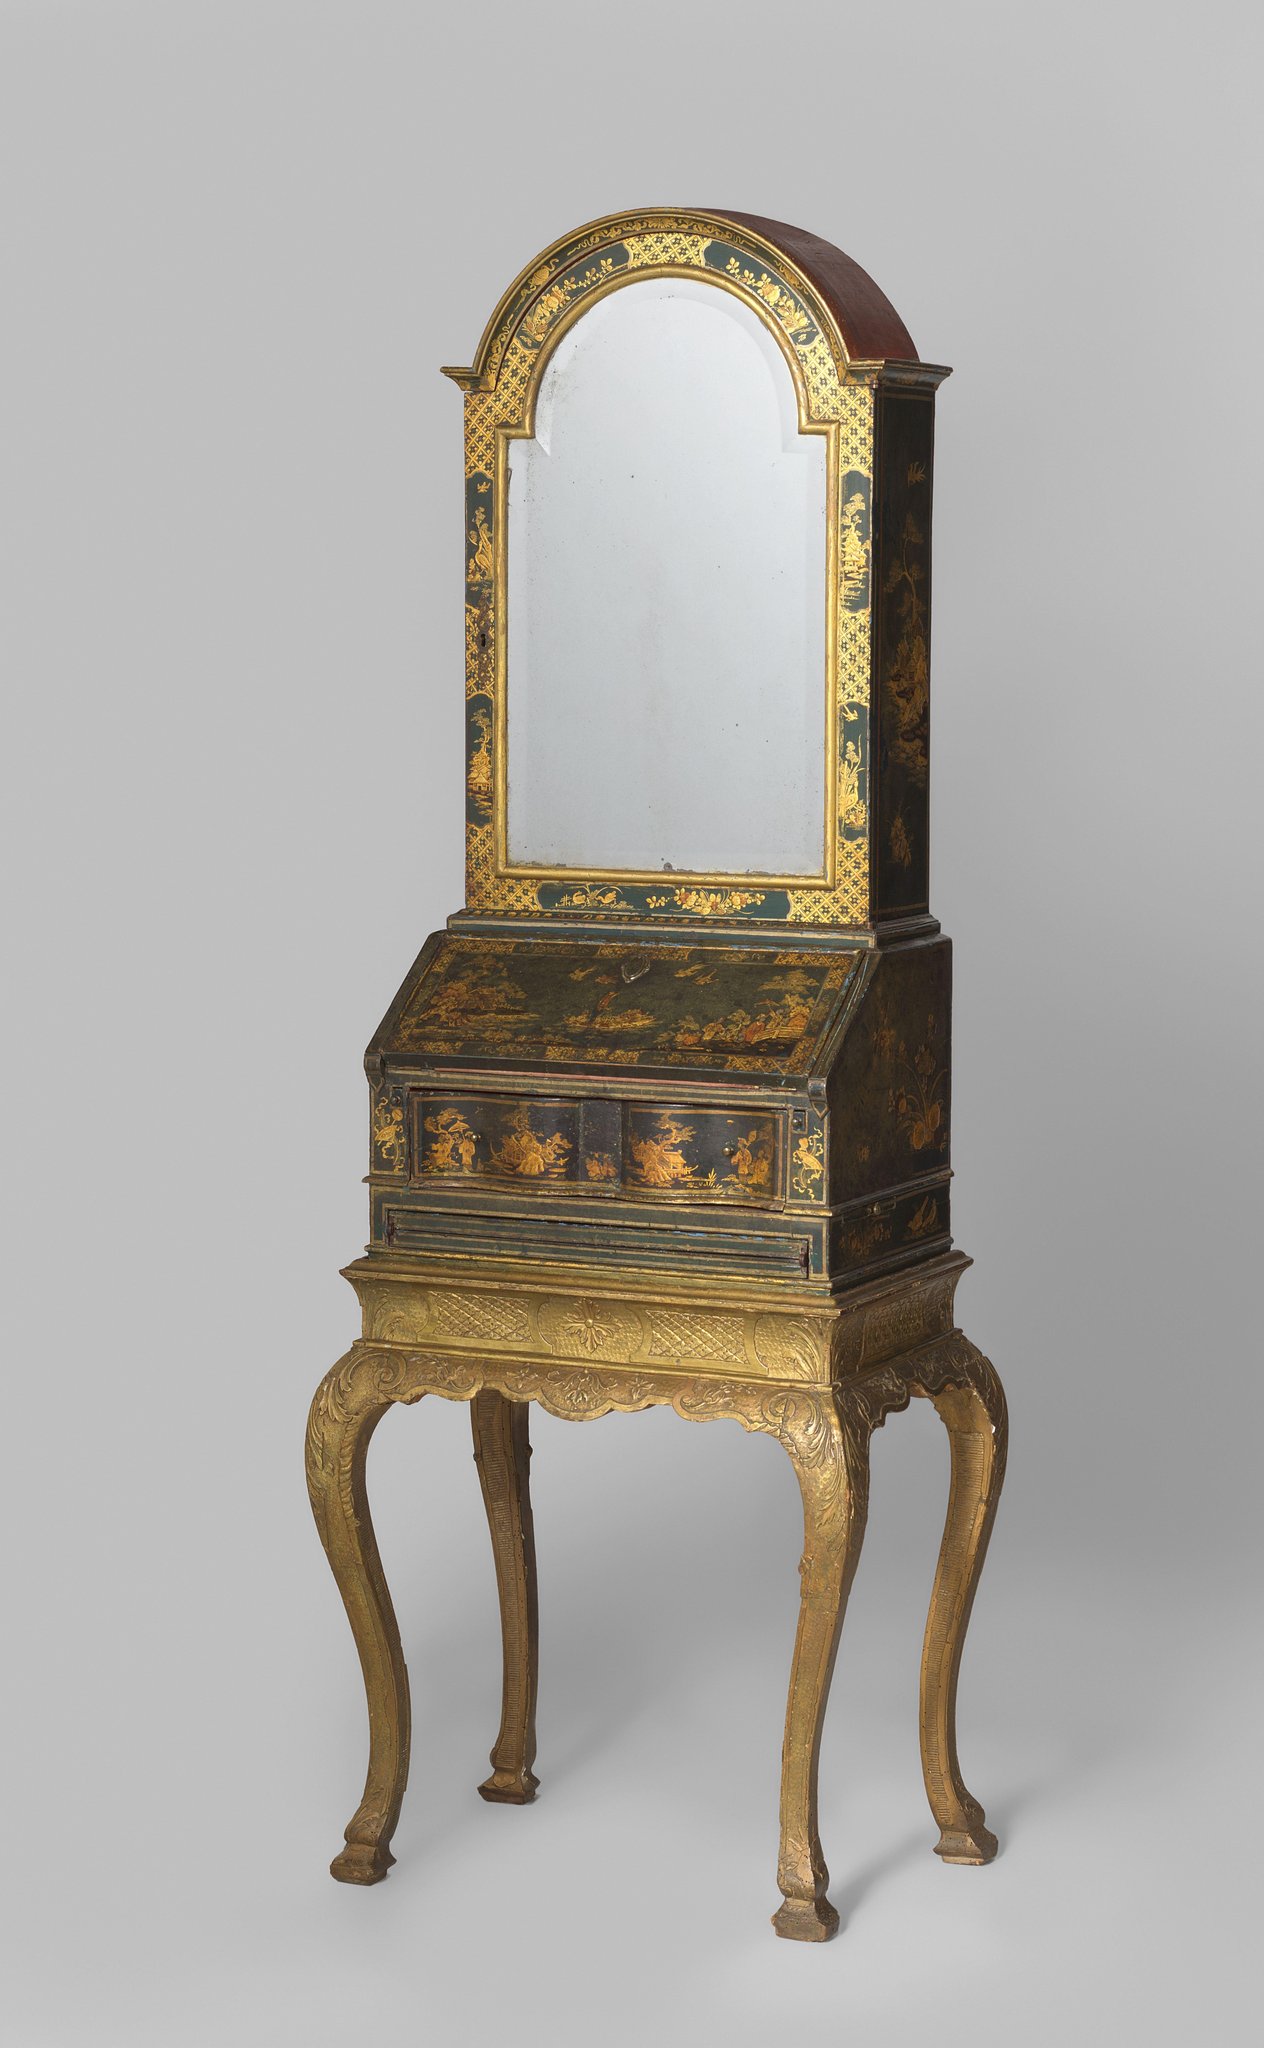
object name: furniture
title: Schrijfkabinet met imitatie Oosters lakwerk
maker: Anonymous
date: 1700-1725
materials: wood, copper, gypsum, velvet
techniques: gilding, lacquer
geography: great britain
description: Bureau-cabinet on stand, pine, gilded and japanned. London, c. 1720.